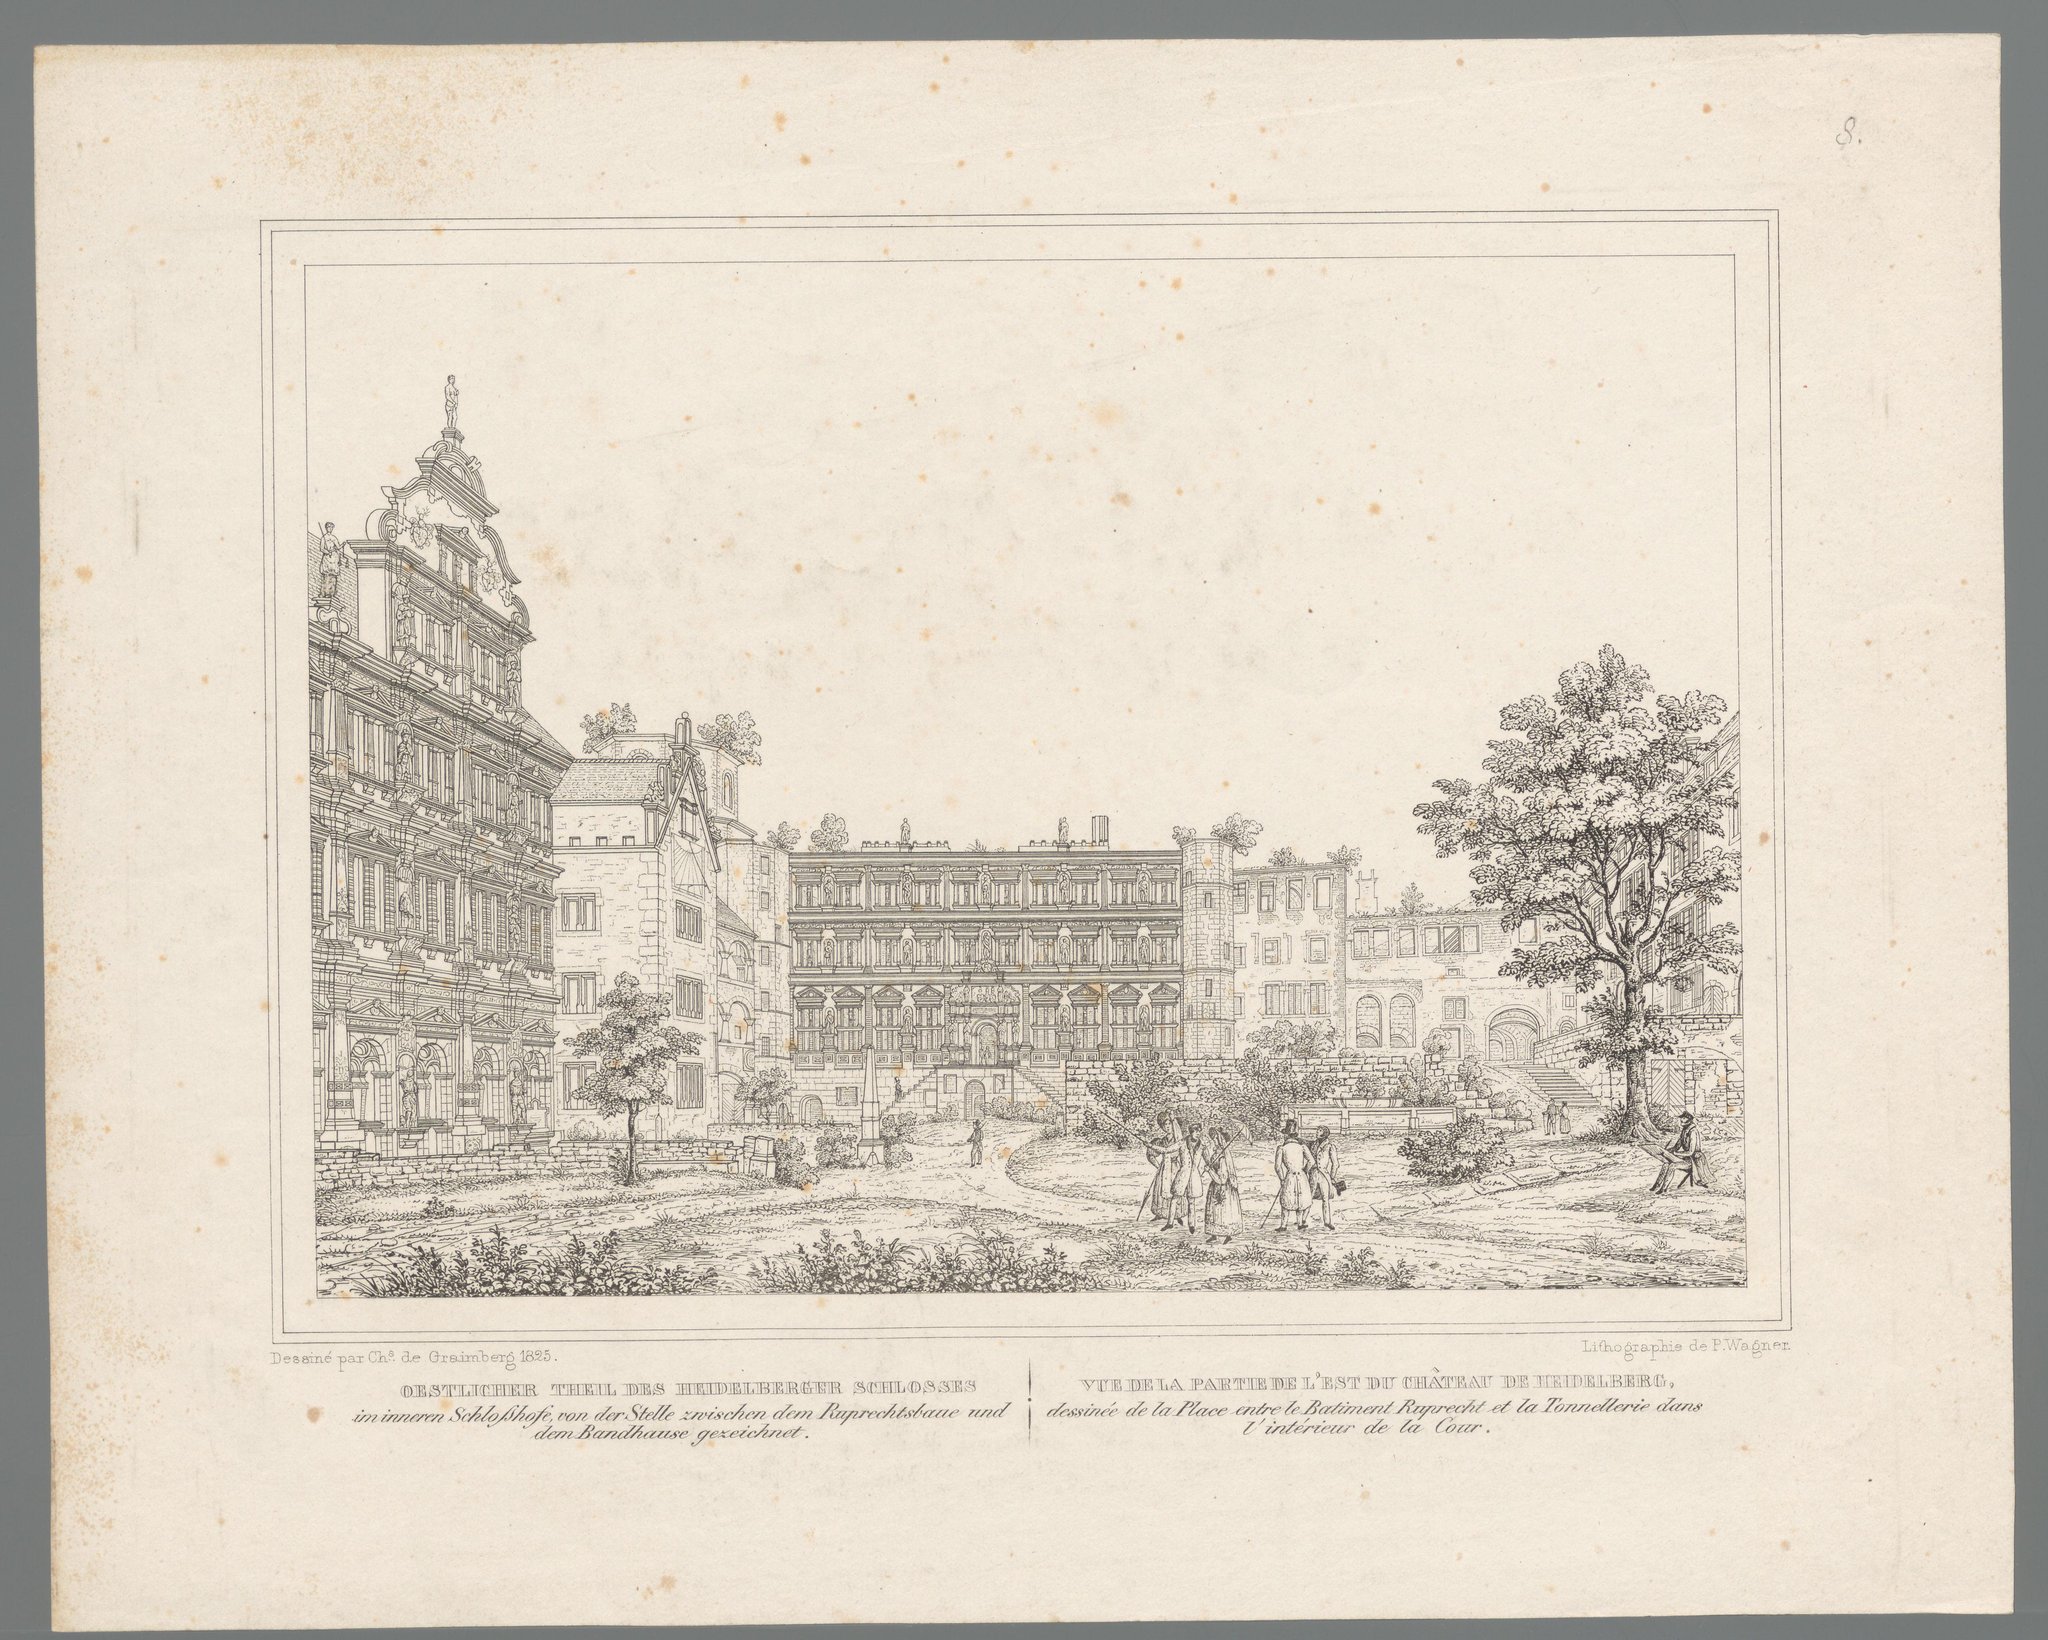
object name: print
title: Gezichten op het Heidelberger Slot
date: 1825-1830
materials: paper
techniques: lithograph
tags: landscape with tower or castle - ii - ideal landscapes (+ city(-scape) with figures, staffage), palace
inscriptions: collector's mark: Lugt 2233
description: Prent maakt deel uit van een serie met gezichten op het Heidelberger Slot. Over deze serie is verder niets bekend. Het betreft (ten minste) negen gezichten op het Heidelberger slot.